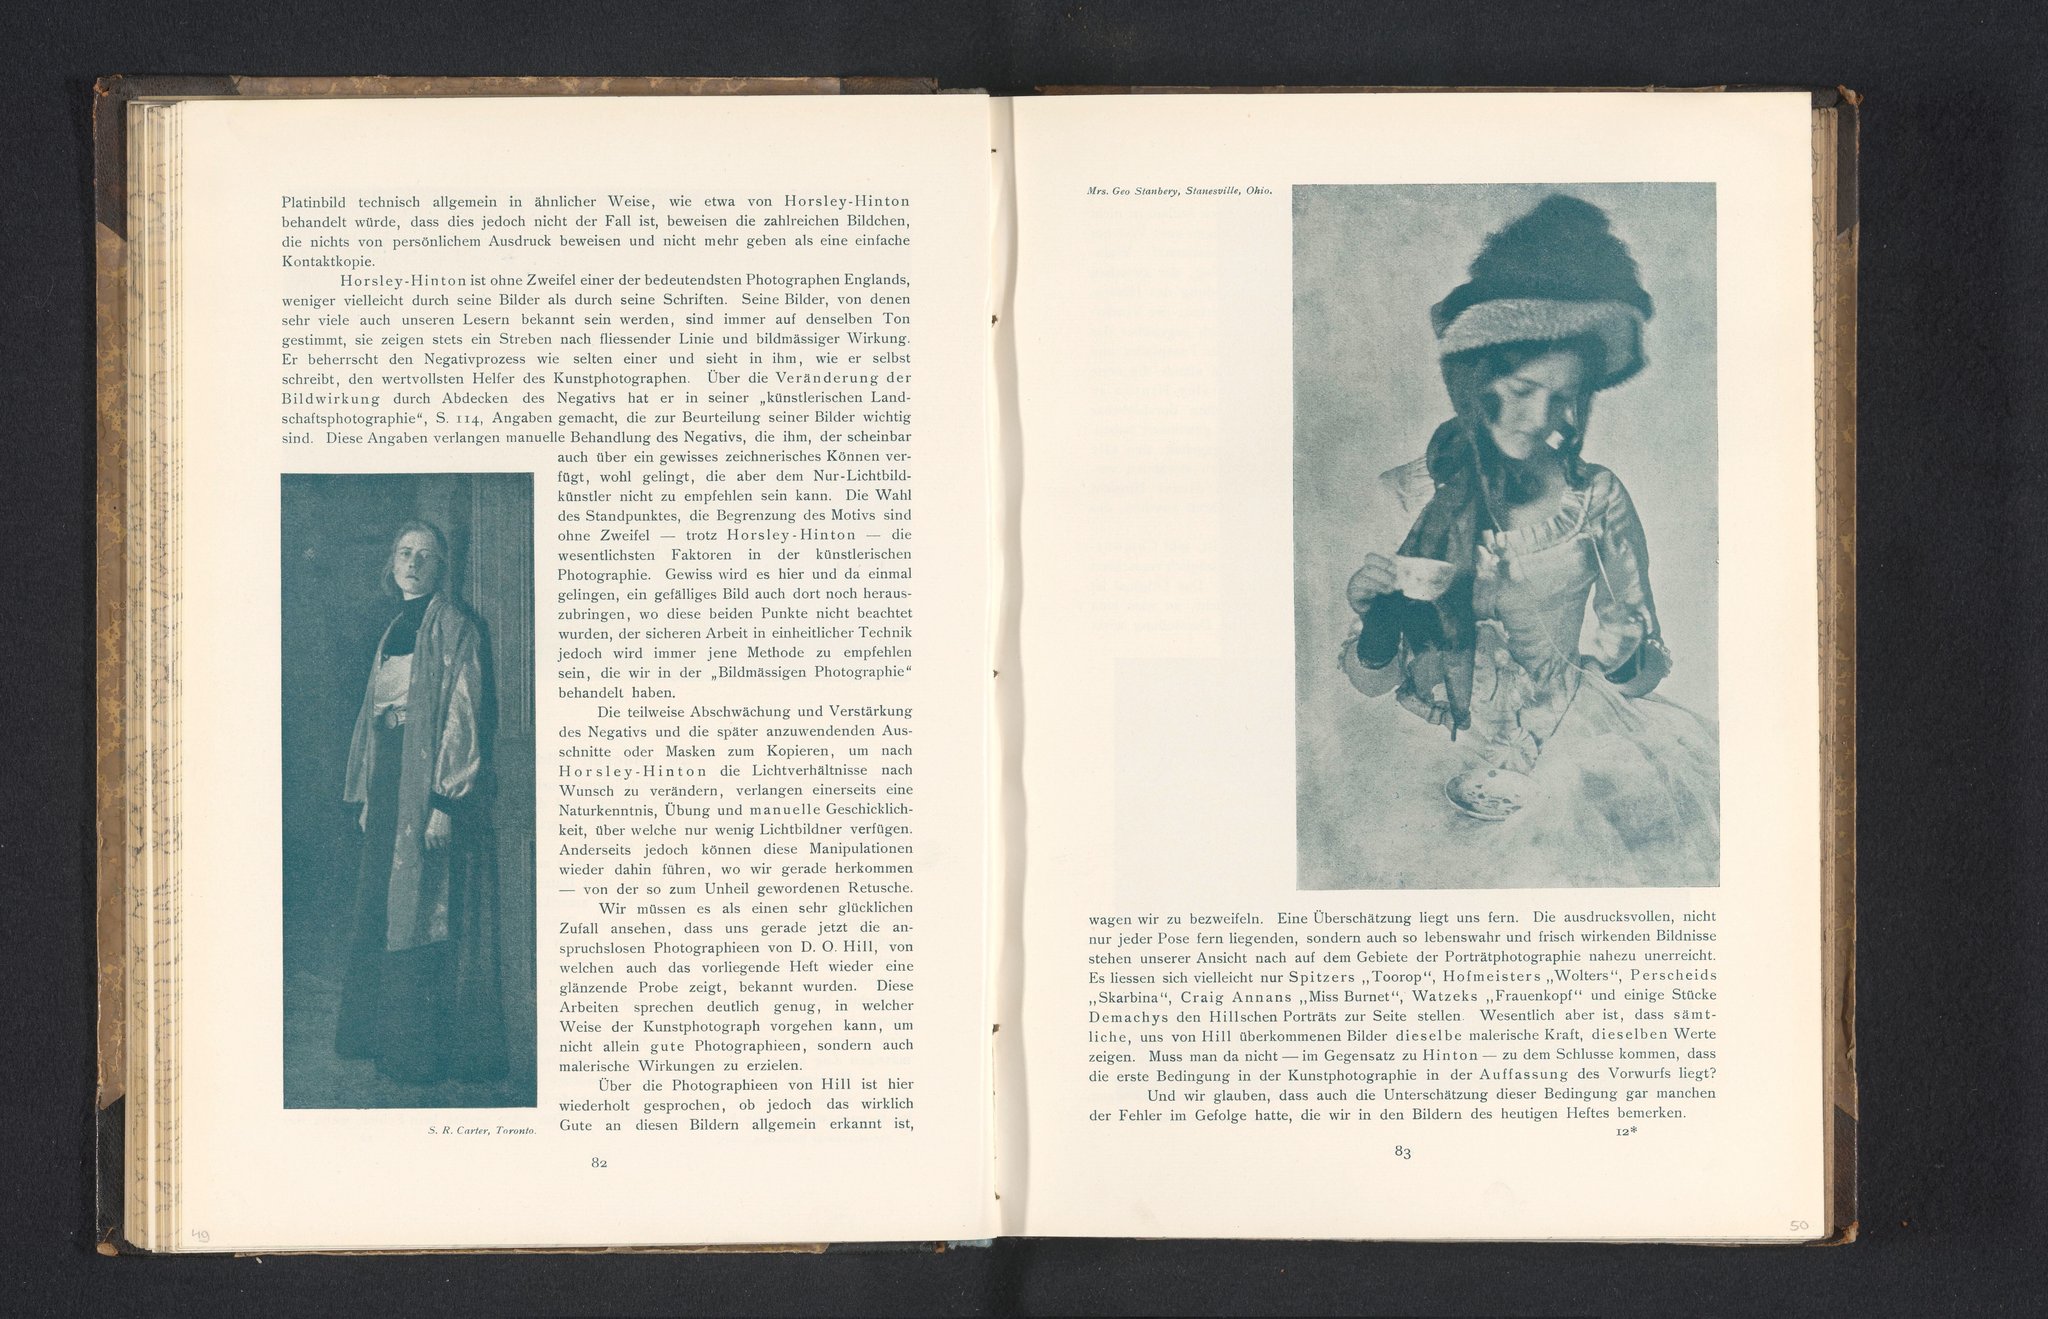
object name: page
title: Portret van een onbekende vrouw met een kopje in haar hand en een schotel in haar schoot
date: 1898-1903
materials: paper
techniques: autotype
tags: historical persons not known by name - bb - woman, cup and saucer